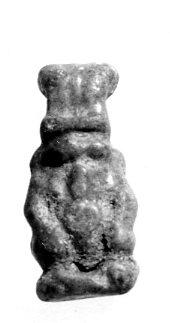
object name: amulet, be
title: Bes amulet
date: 664-332 BCE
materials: faience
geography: egypt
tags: bes